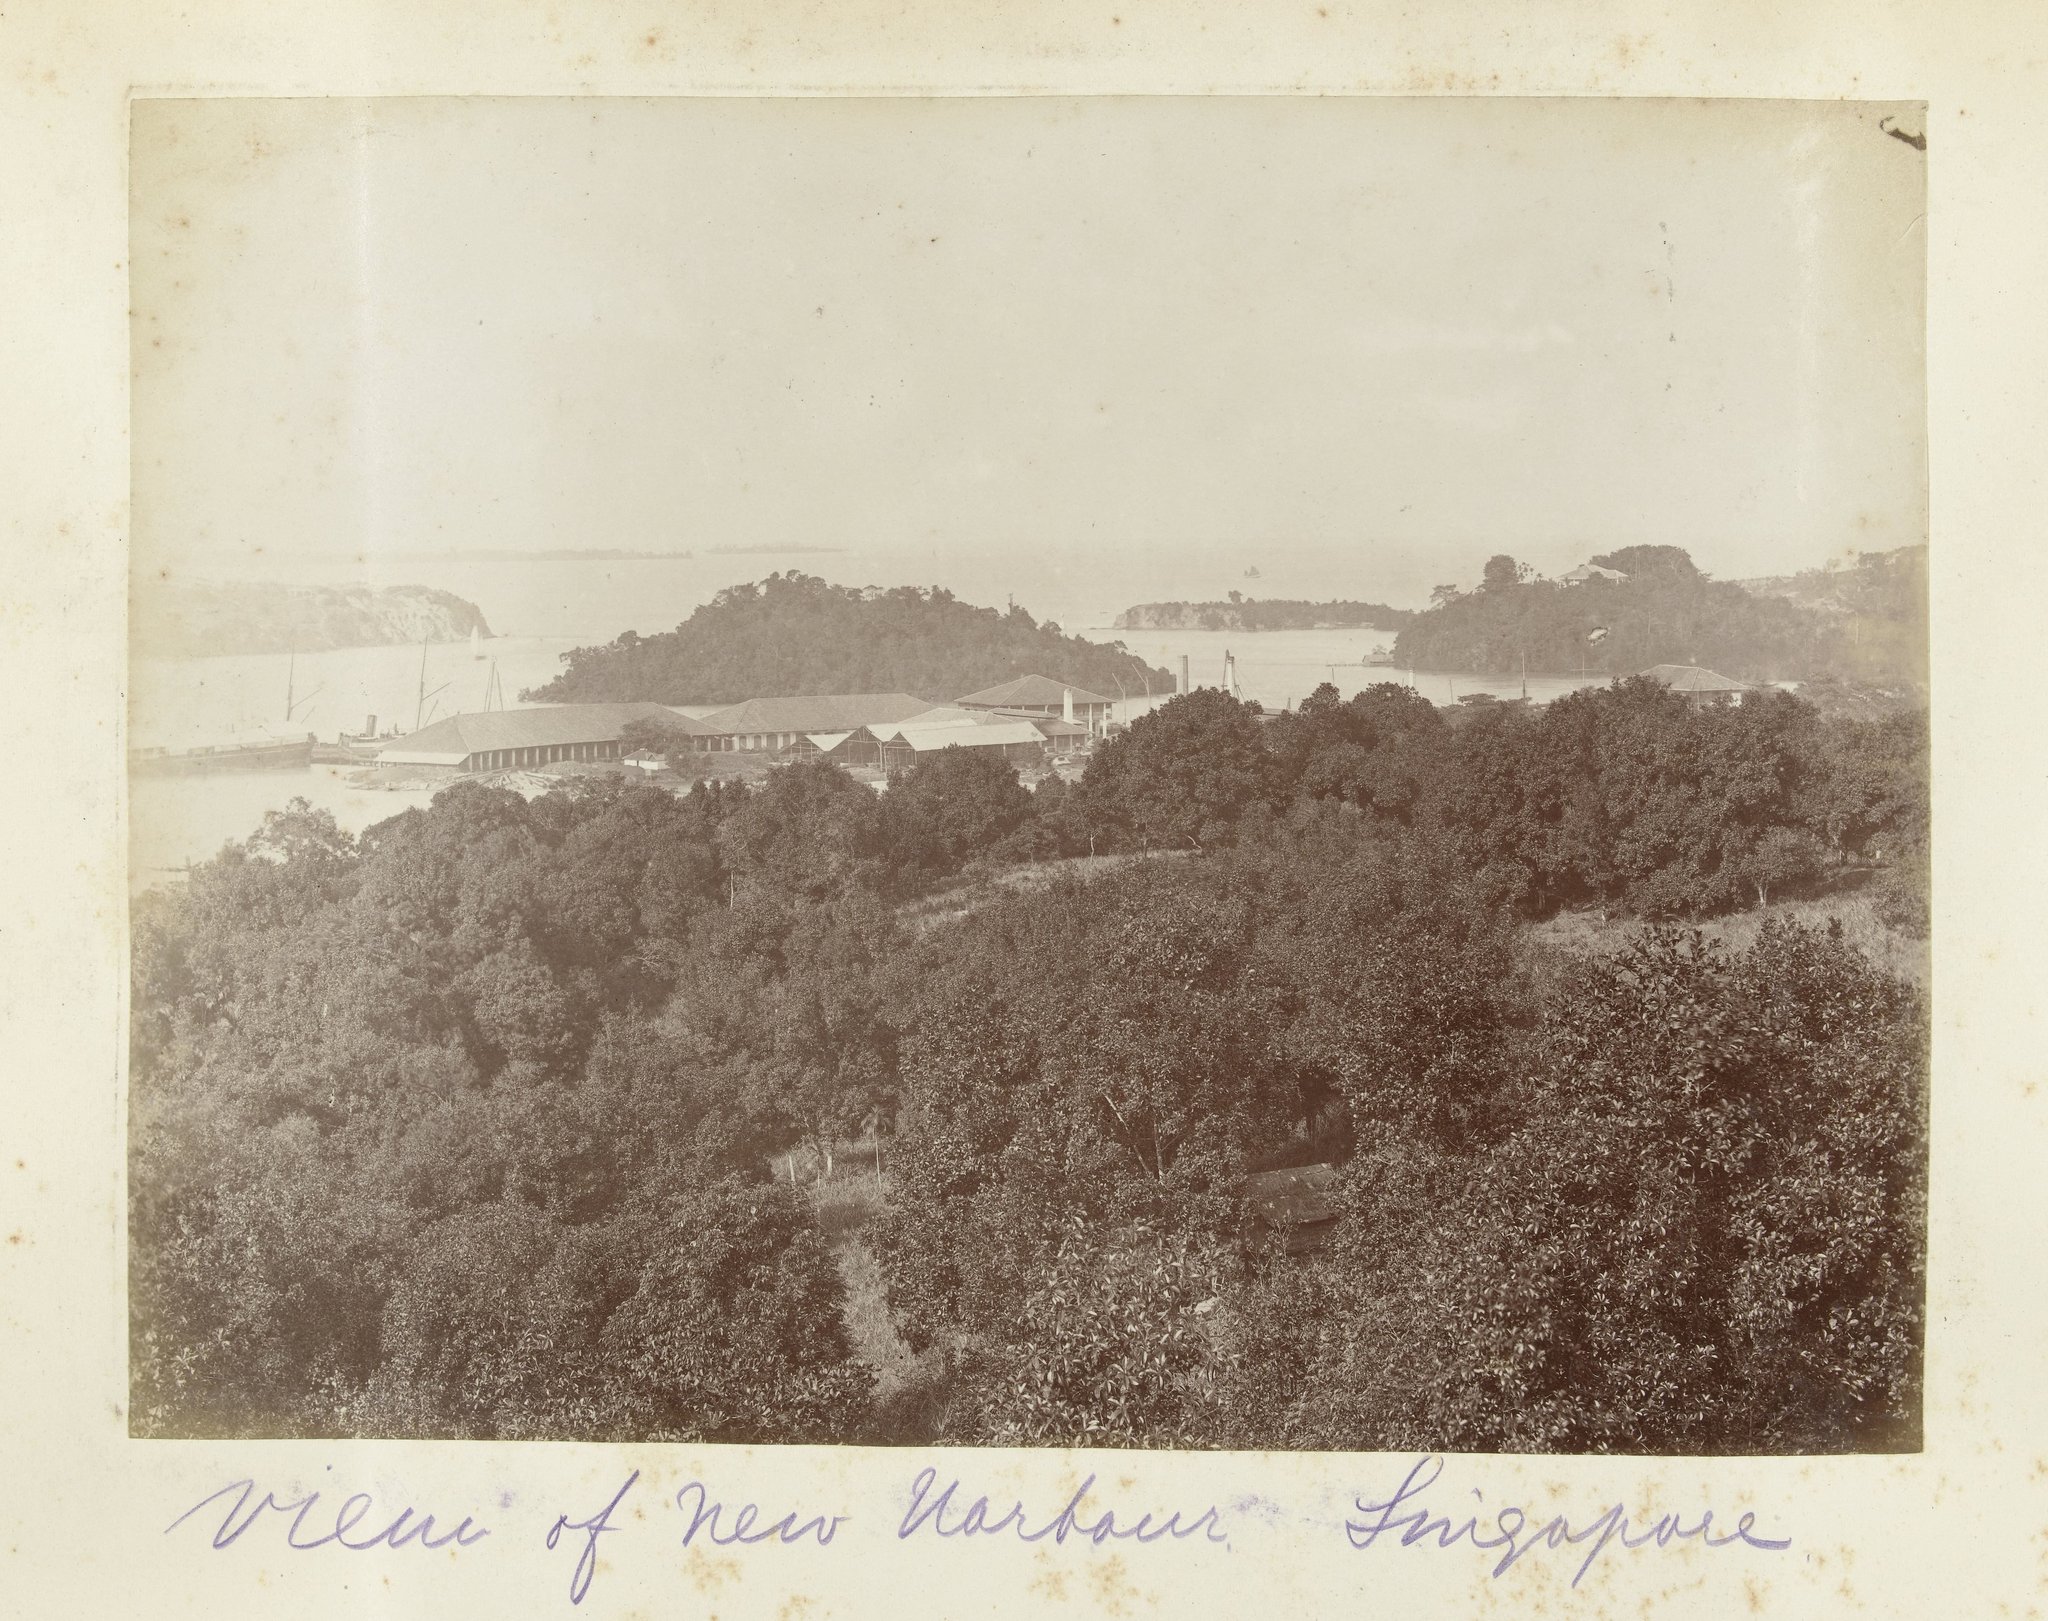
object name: photograph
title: Zicht op de haven van Singapore en de nabij gelegen bebossing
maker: Anonymous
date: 1890-1910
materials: cardboard, paper, photographic support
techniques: gelatin silver print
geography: netherlands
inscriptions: caption: ‘View of new Harbour, Singapore’